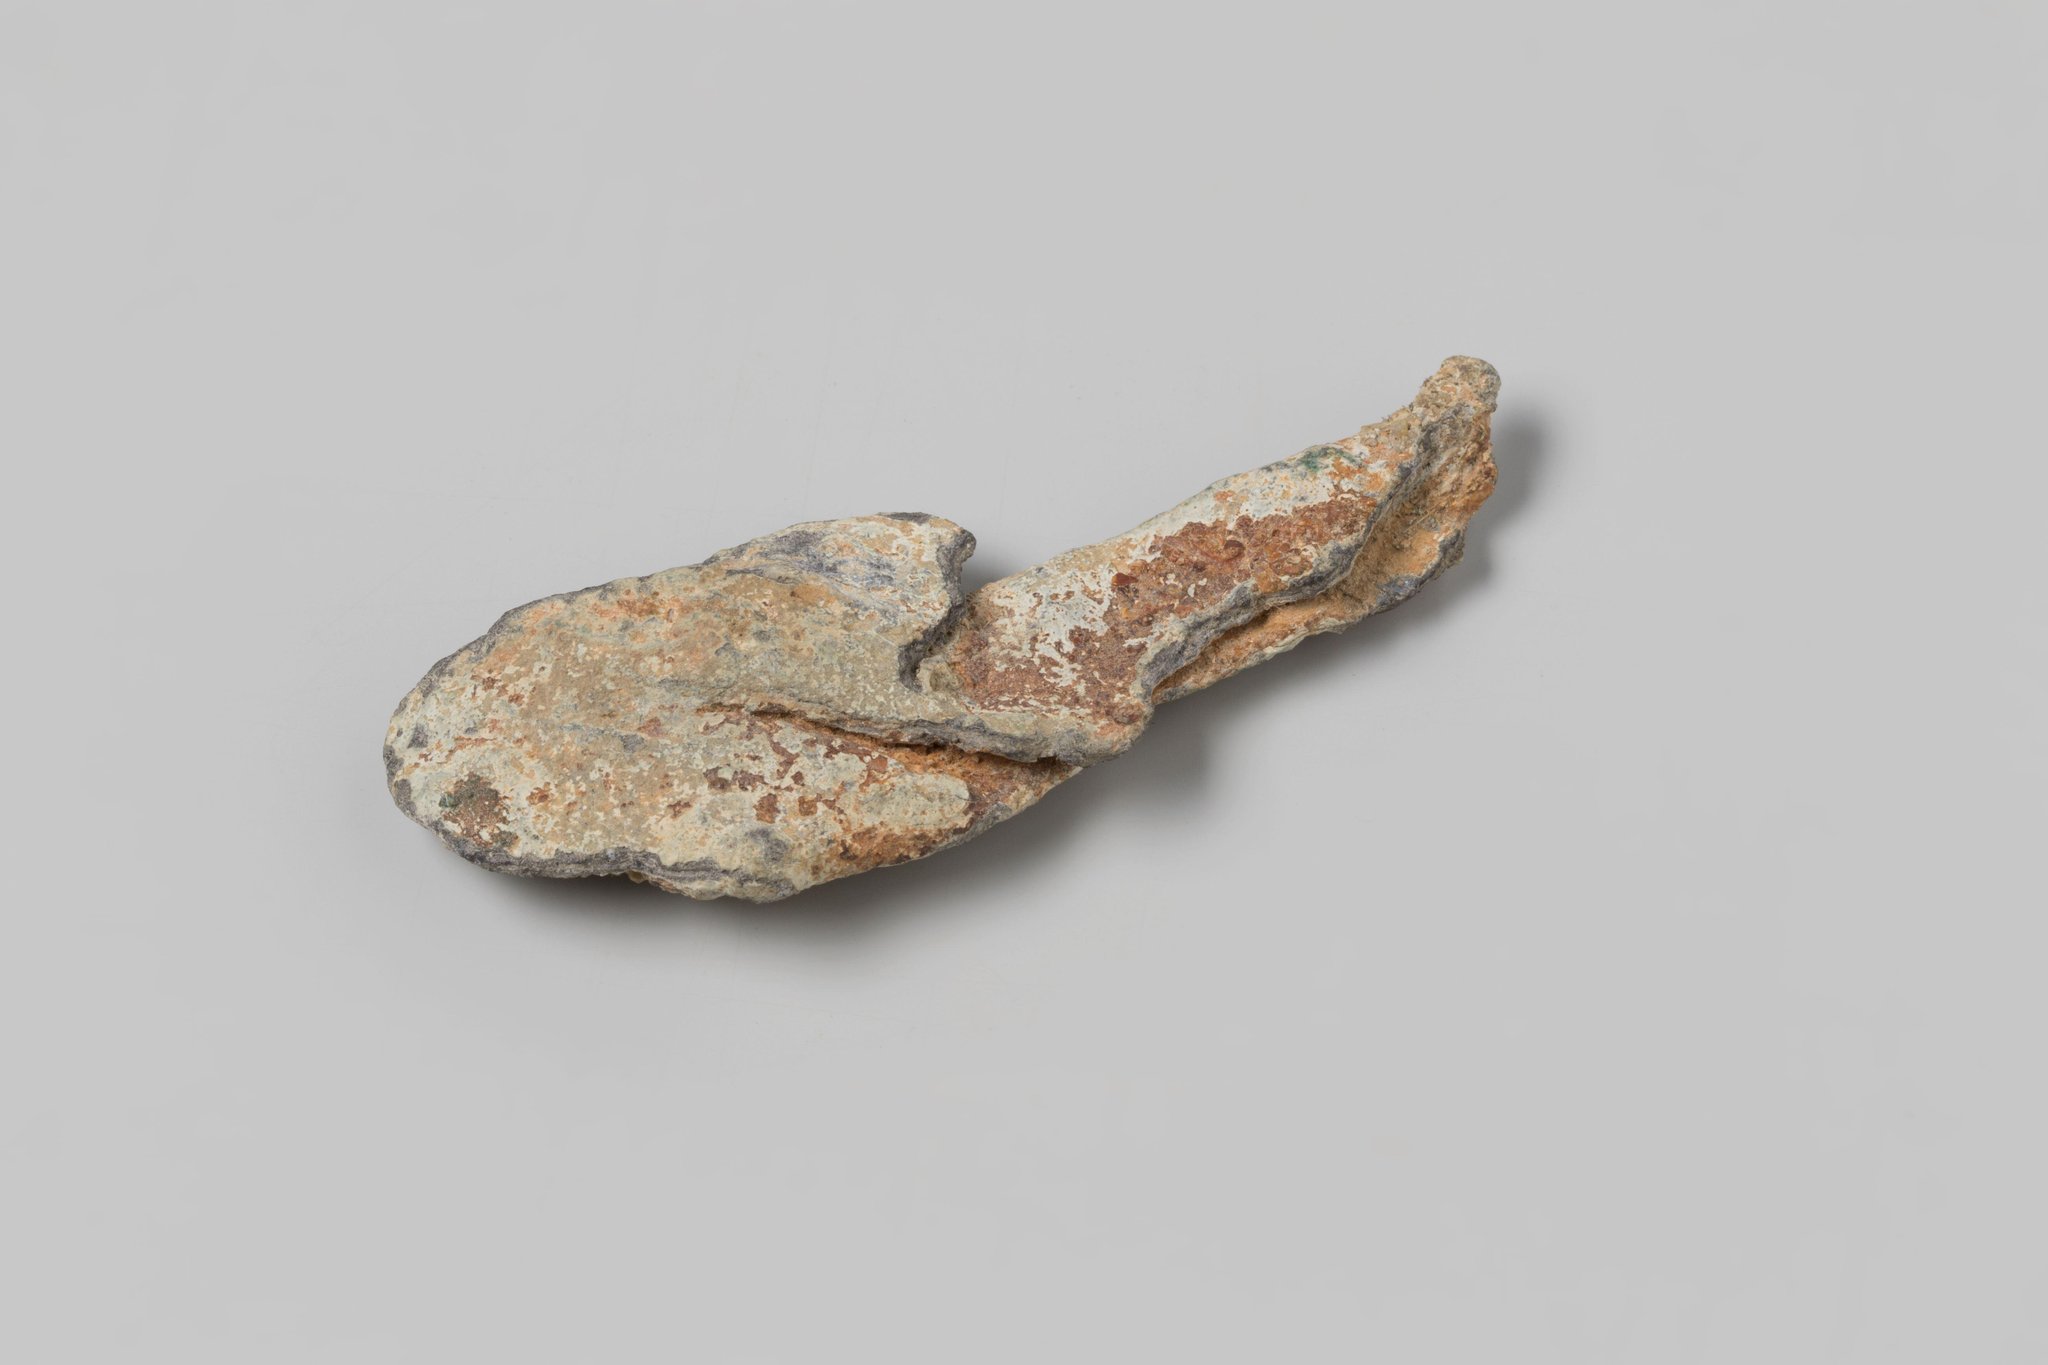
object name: fragment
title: Fragment lood uit het wrak van de Oost-Indiëvaarder Hollandia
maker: Anonymous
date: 1700-1743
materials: lead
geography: netherlands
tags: verenigde oostindische compagnie, hollandia (schip), annet